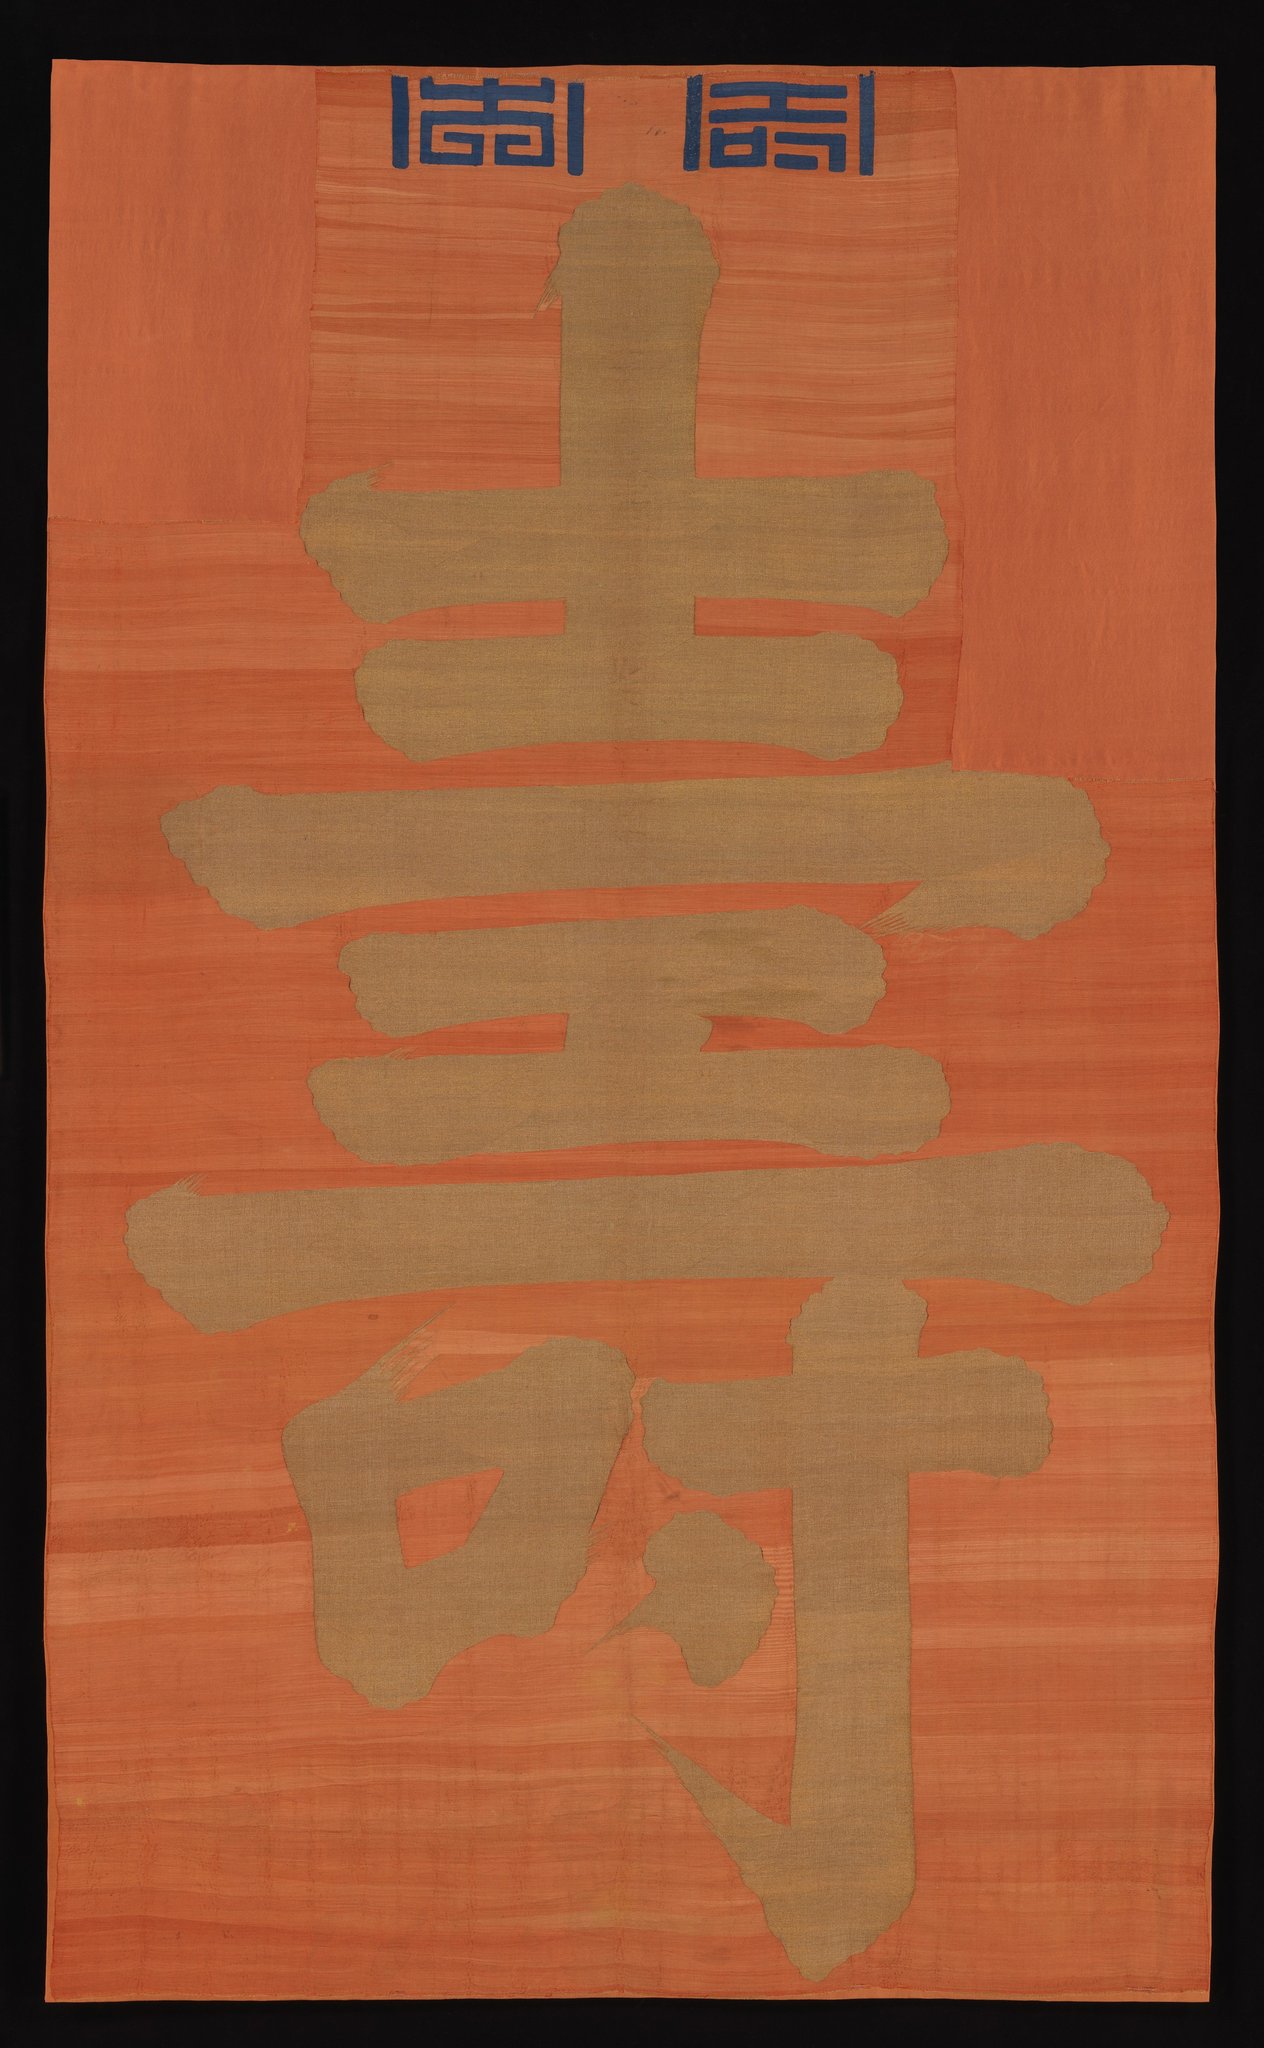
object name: panel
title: Panel with the Chinese Character for Longevity (Shou)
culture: chinese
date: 1701-1800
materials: metal thread, silk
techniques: tapestry